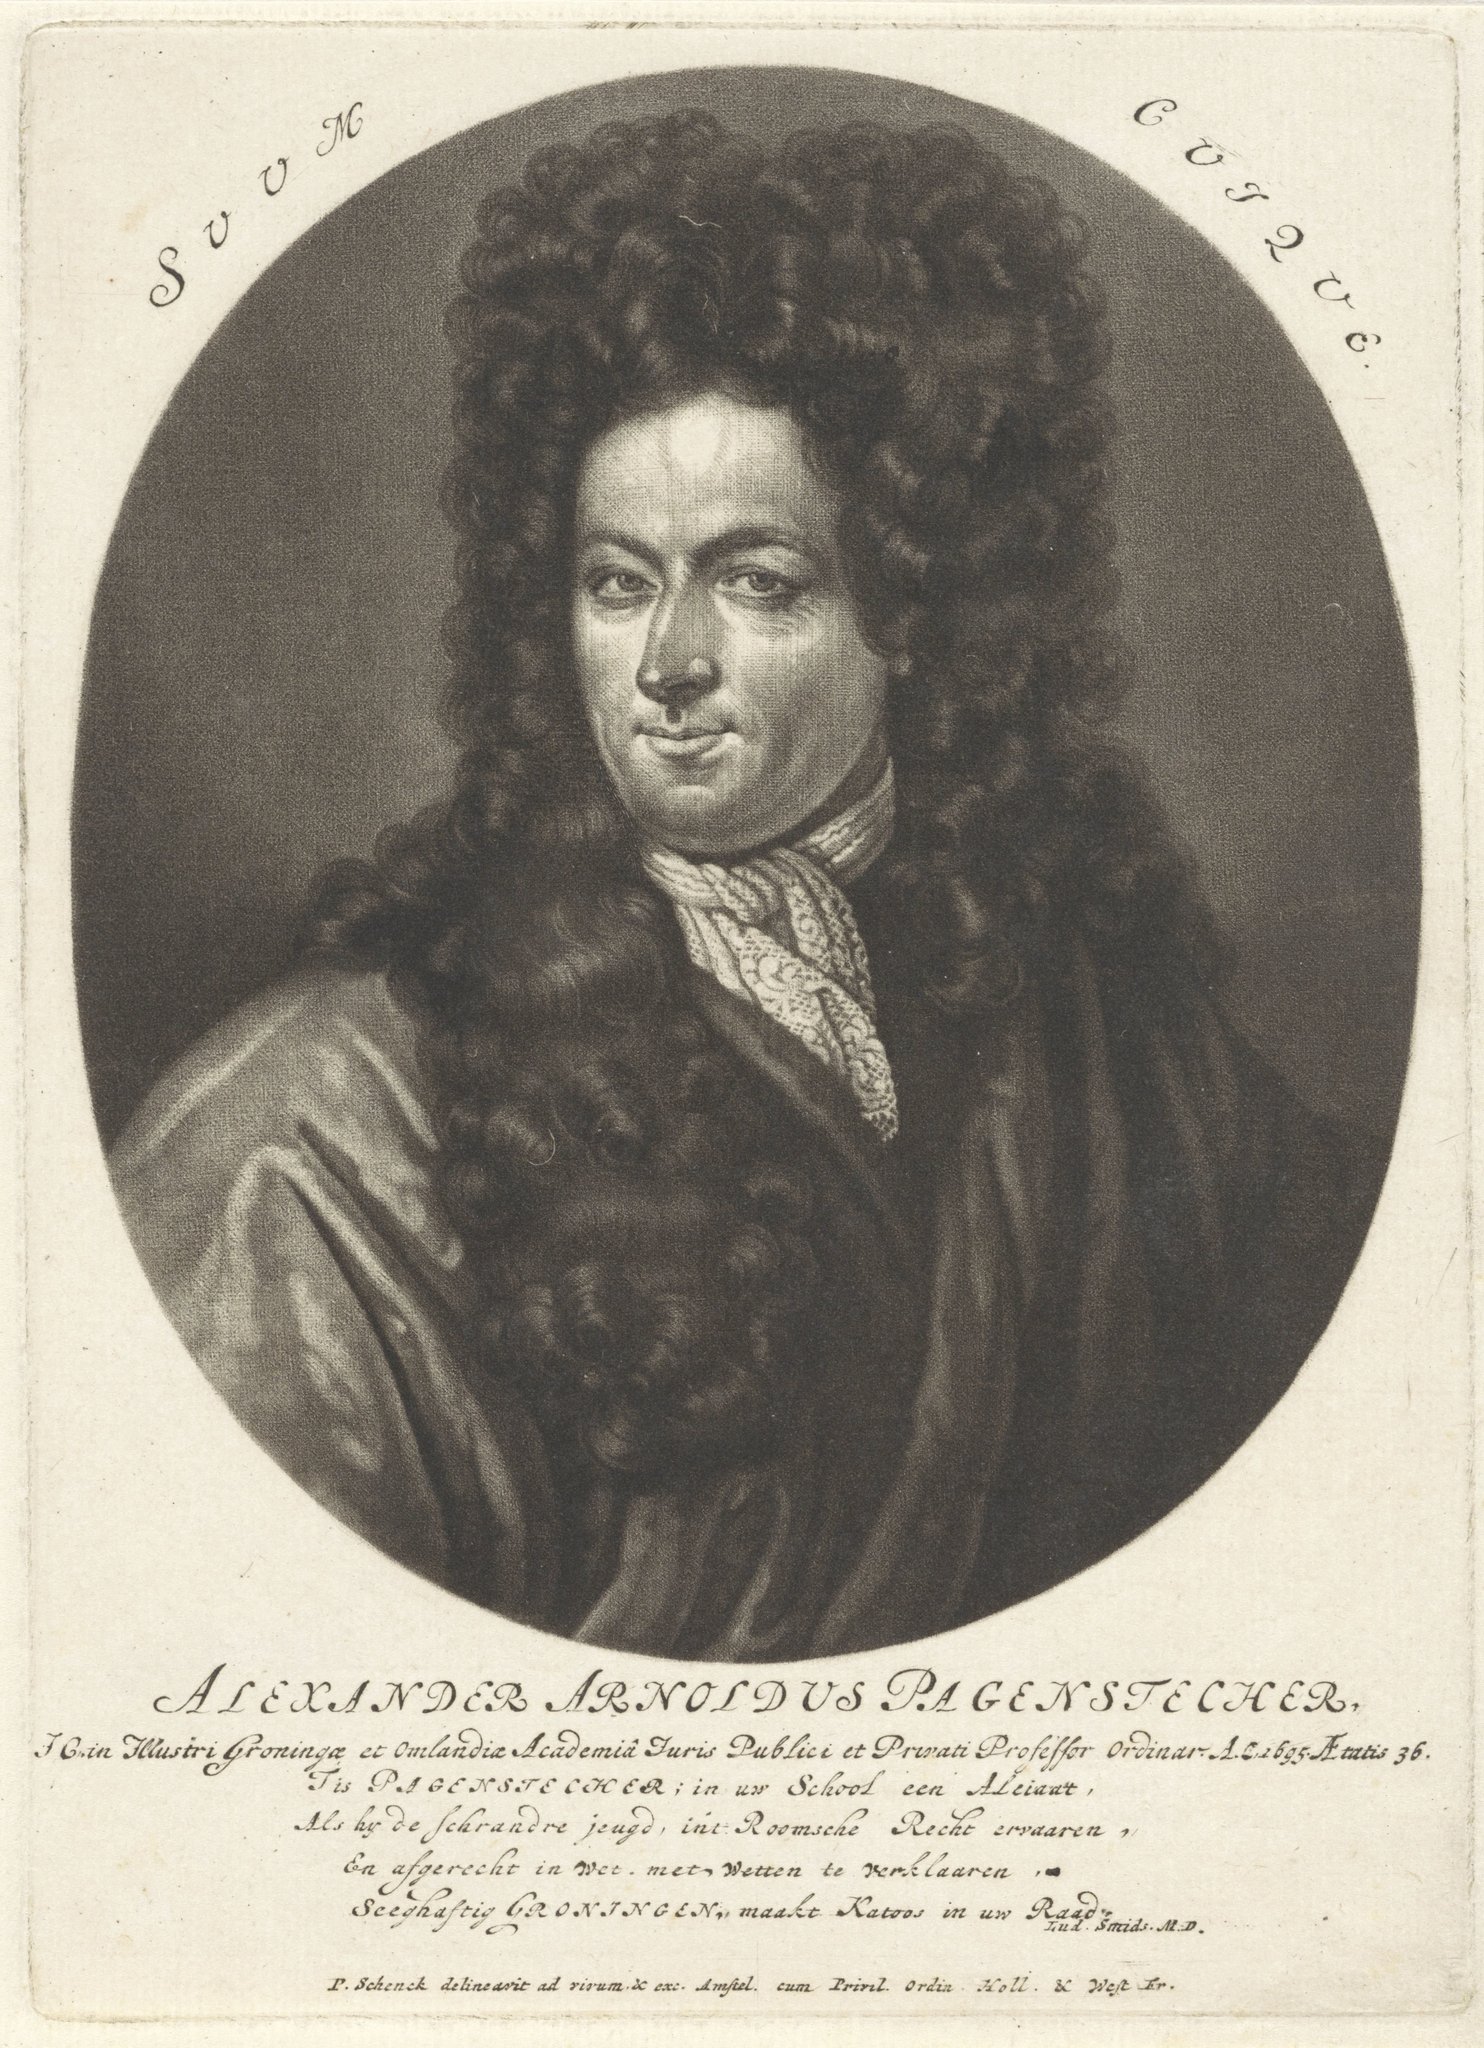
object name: print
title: Portret van de jurist en hoogleraar Alexander Arnold Pagenstecher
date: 1695-1713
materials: paper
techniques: engraving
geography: amsterdam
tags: wig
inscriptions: collector's mark: Lugt 2228